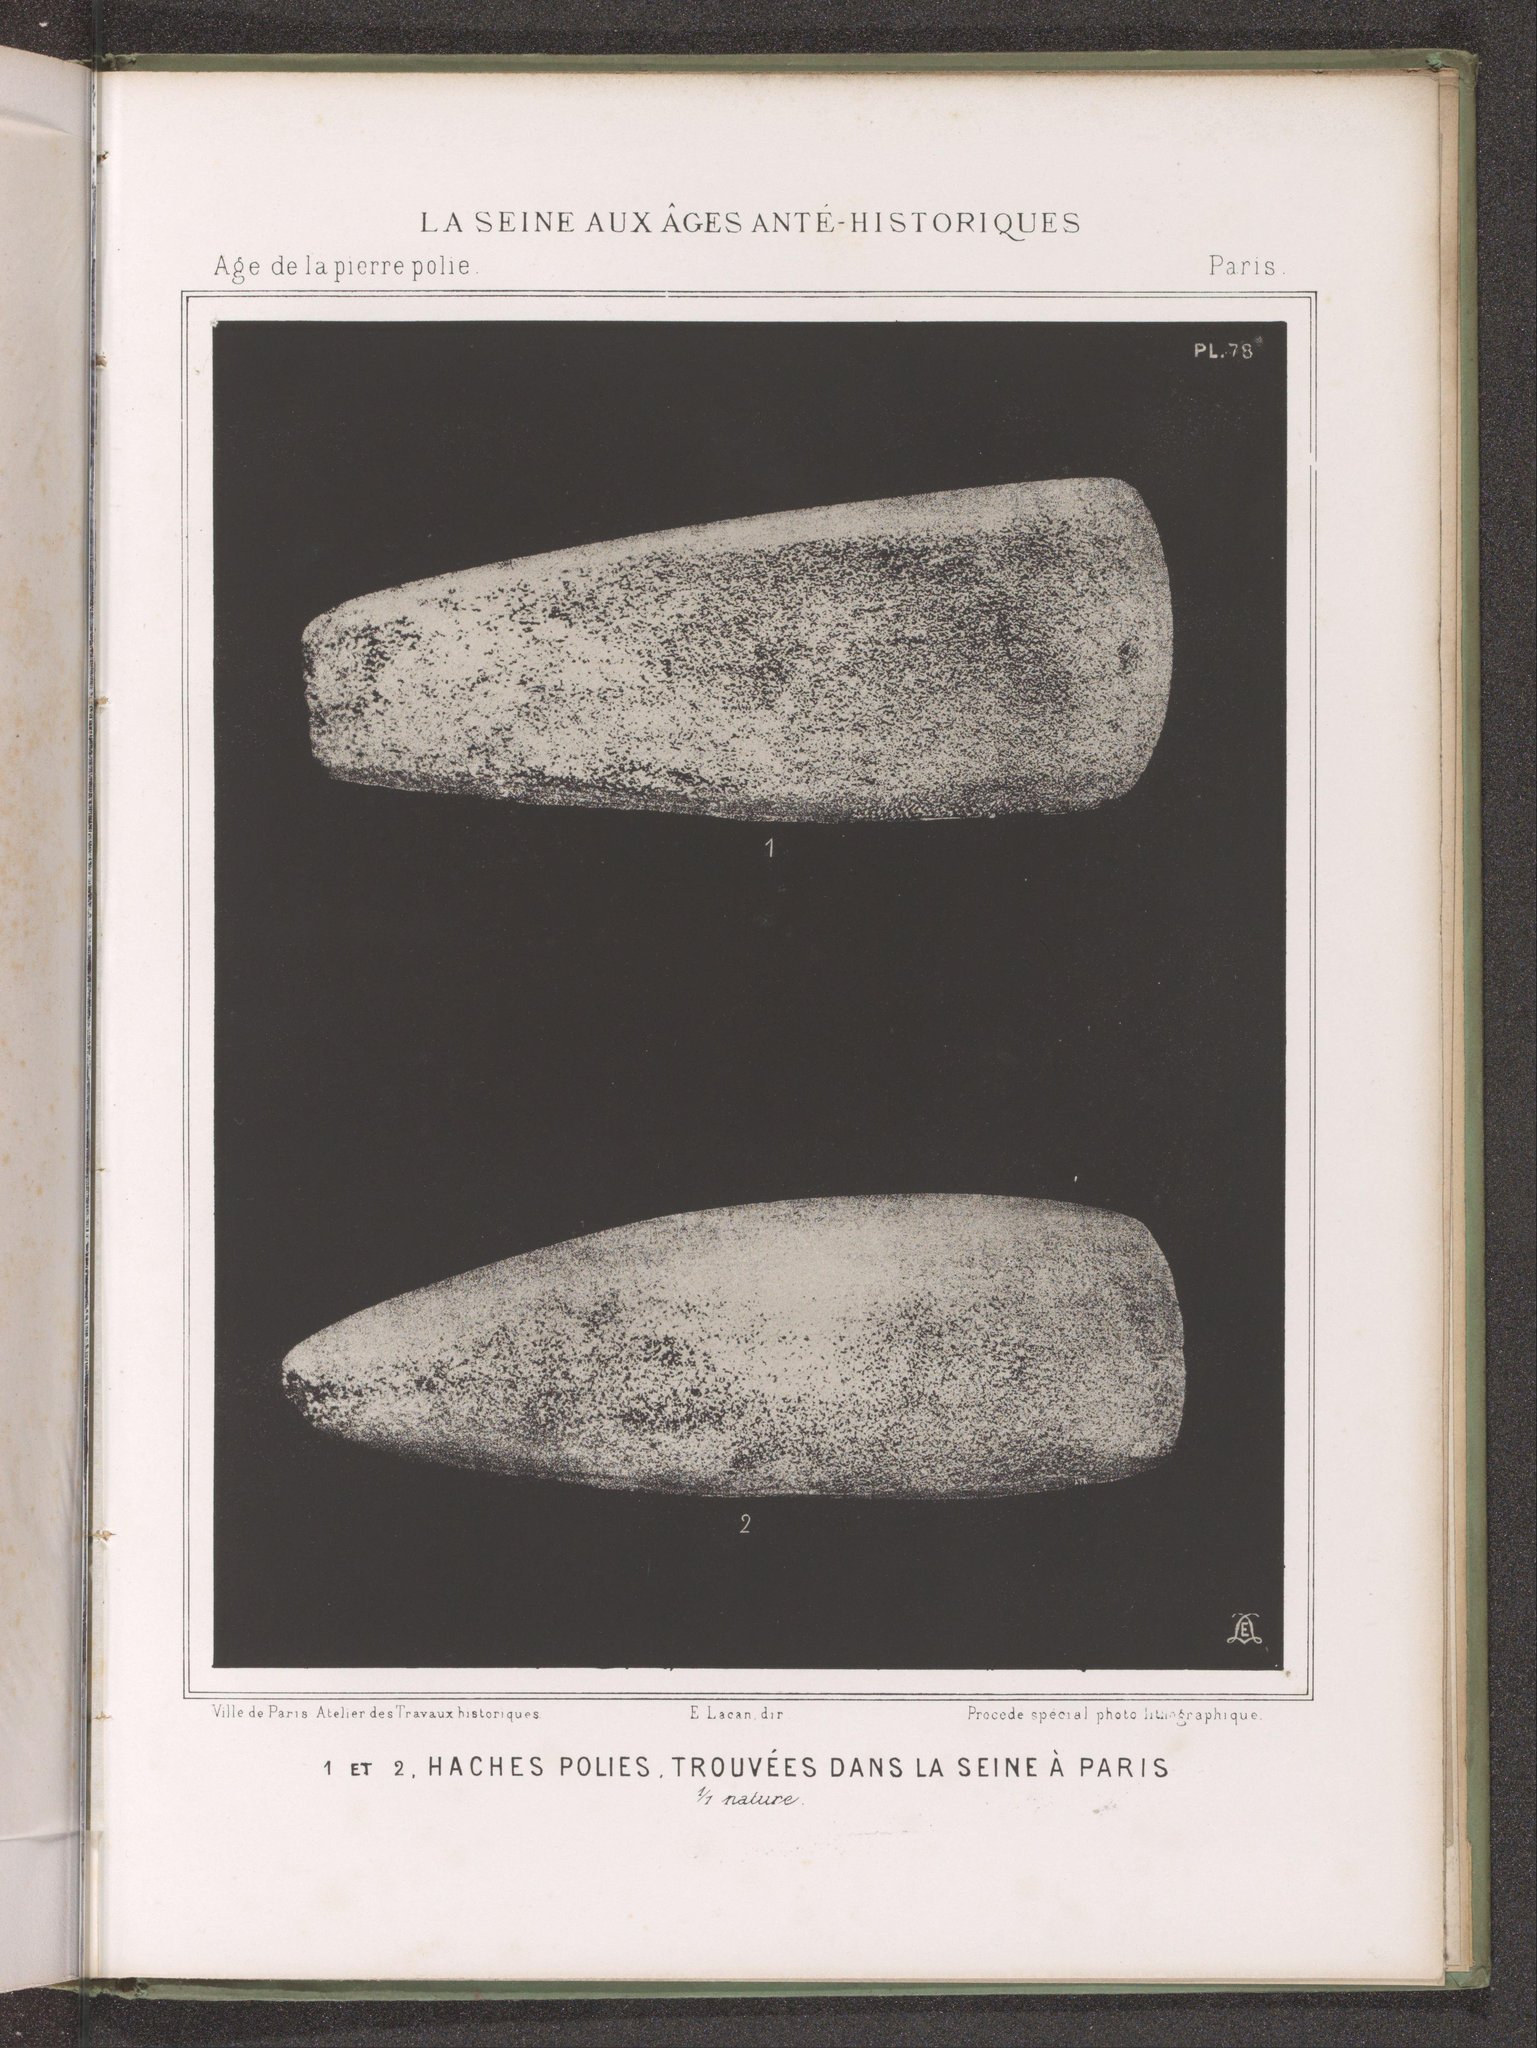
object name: photomechanical print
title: Gepolijste bijlen gevonden in de Seine te Parijs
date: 1860-1869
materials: paper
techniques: photolithography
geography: france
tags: animals (+ skeleton of an animal), palaeontology, france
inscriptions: inscription: ‘Ville de Paris. Atelier des Travaux historiques. E. Lacan, dir. Procédé spécial photo-lithographique.’, number: ‘Pl. 78’, monogram: ‘LEL’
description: Voor plek prent in boek: zie nummer onder 'Opschriften / Merken'.